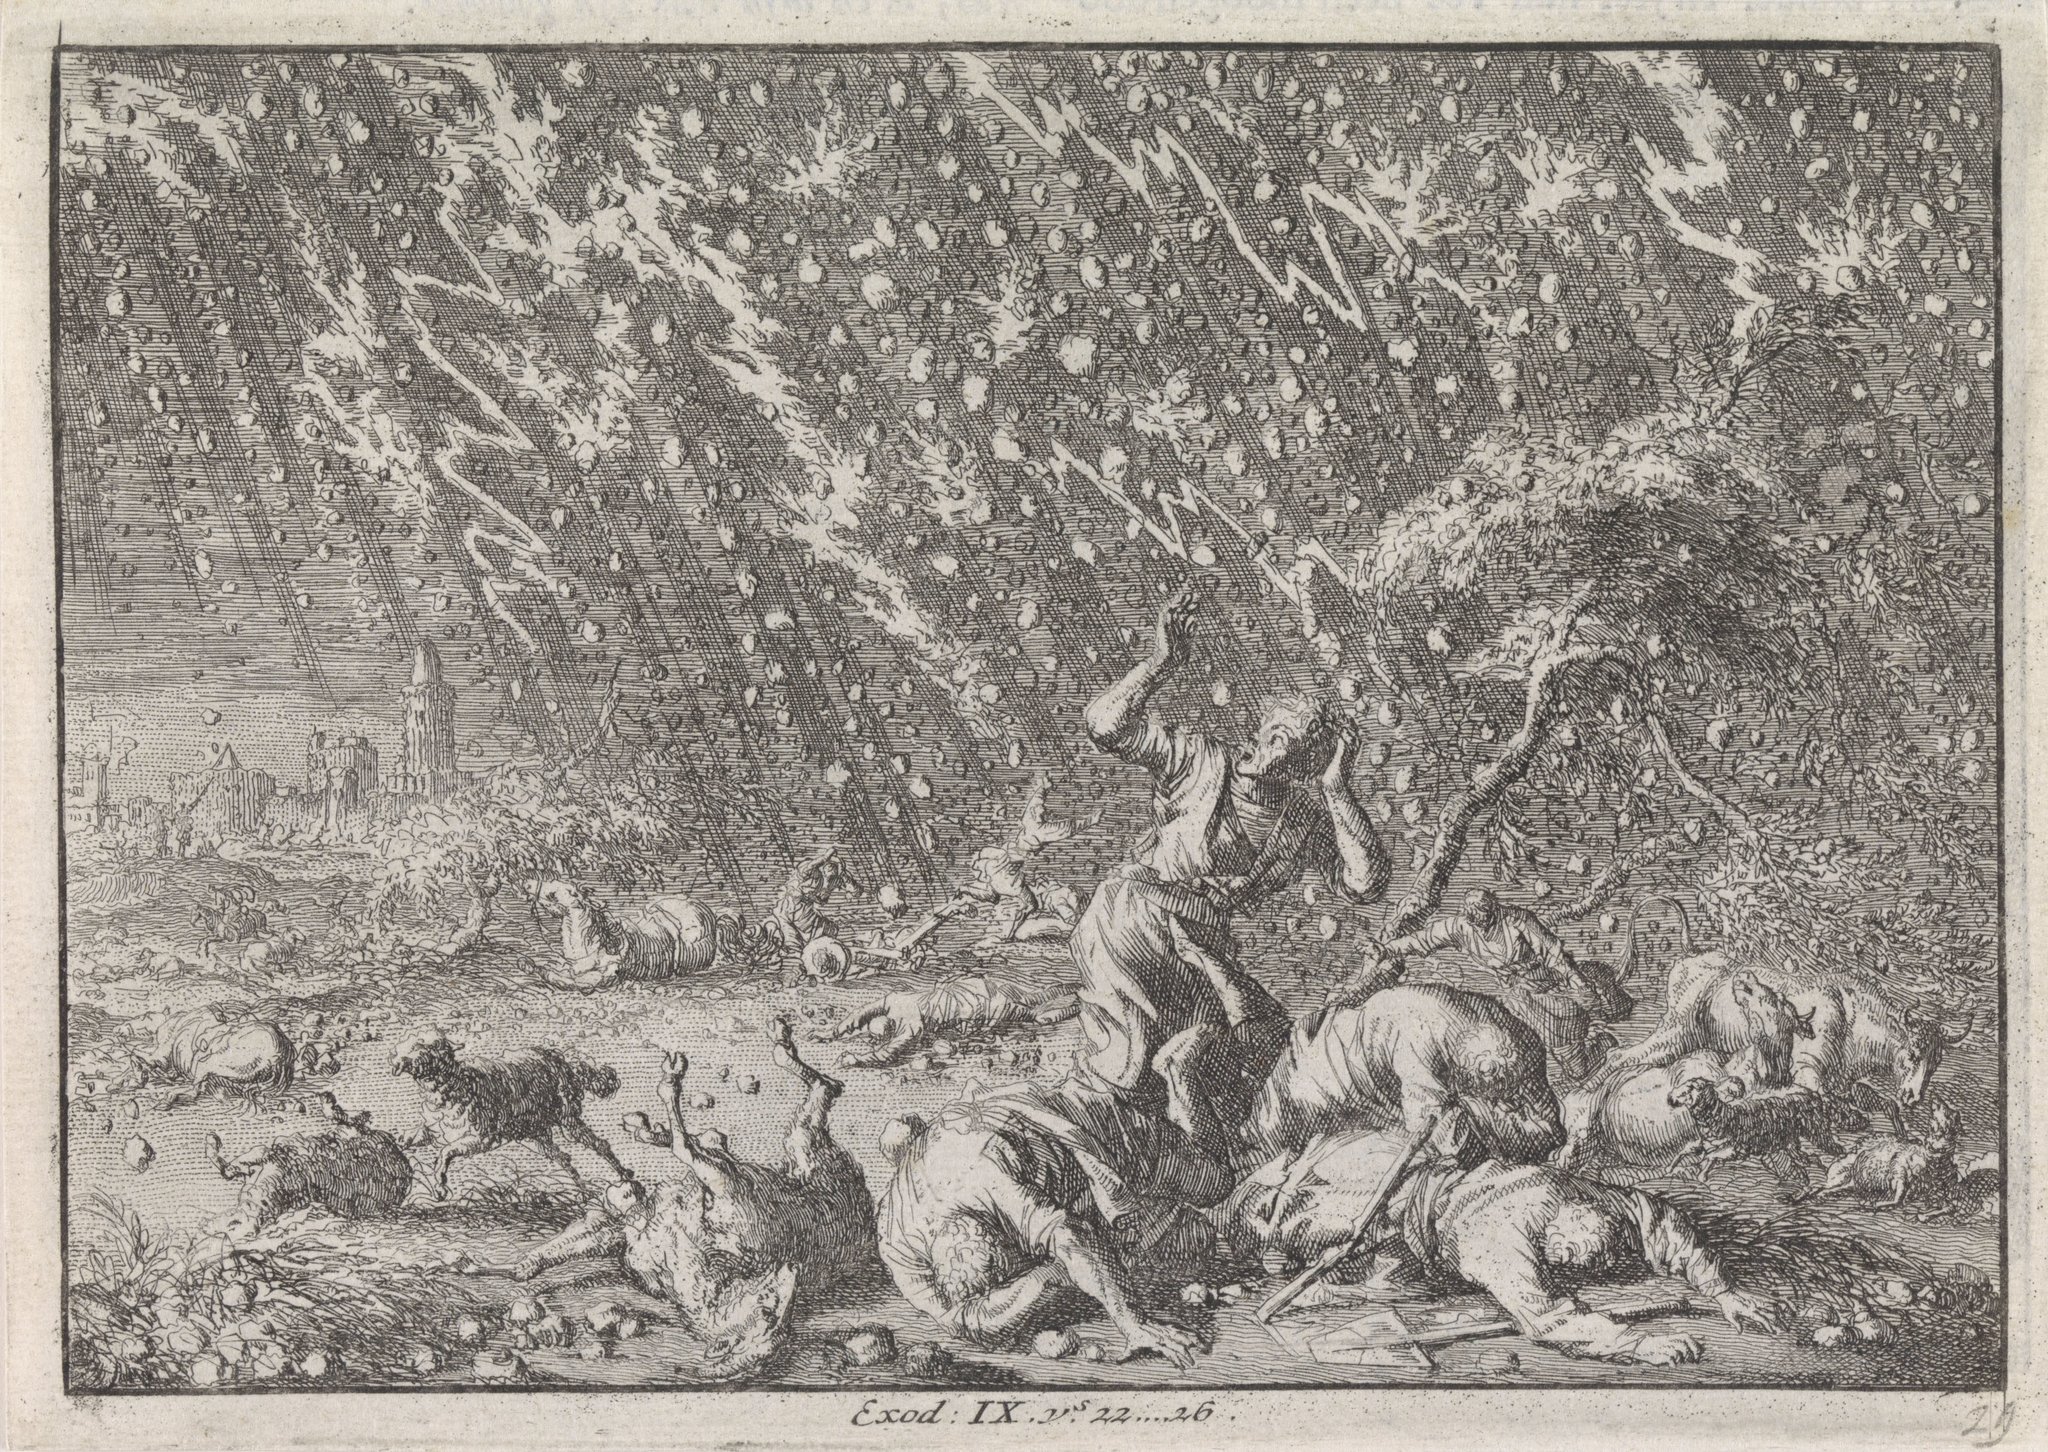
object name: print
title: Plaag van hagel en onweer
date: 1703-1762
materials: paper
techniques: etching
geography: amsterdam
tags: hail, the plague of hail: moses raises his rod towards the sky, and hail and fire fall to the ground, thunderstorm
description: De prent komt een eerste keer voor als boekillustratie voor David Martin. Historie des Ouden en Nieuwen Testaments. Amsterdam, Pieter Mortier, 1703. Deel I. De boekillustraties voor de Mortierbijbel hebben verschillende staten en kopieën, waarbij de chronologische volgorde moeilijk te achterhalen valt. Als boekillustraties werden ze bovendien herhaaldelijk opnieuw gebruikt voor andere boekwerken.